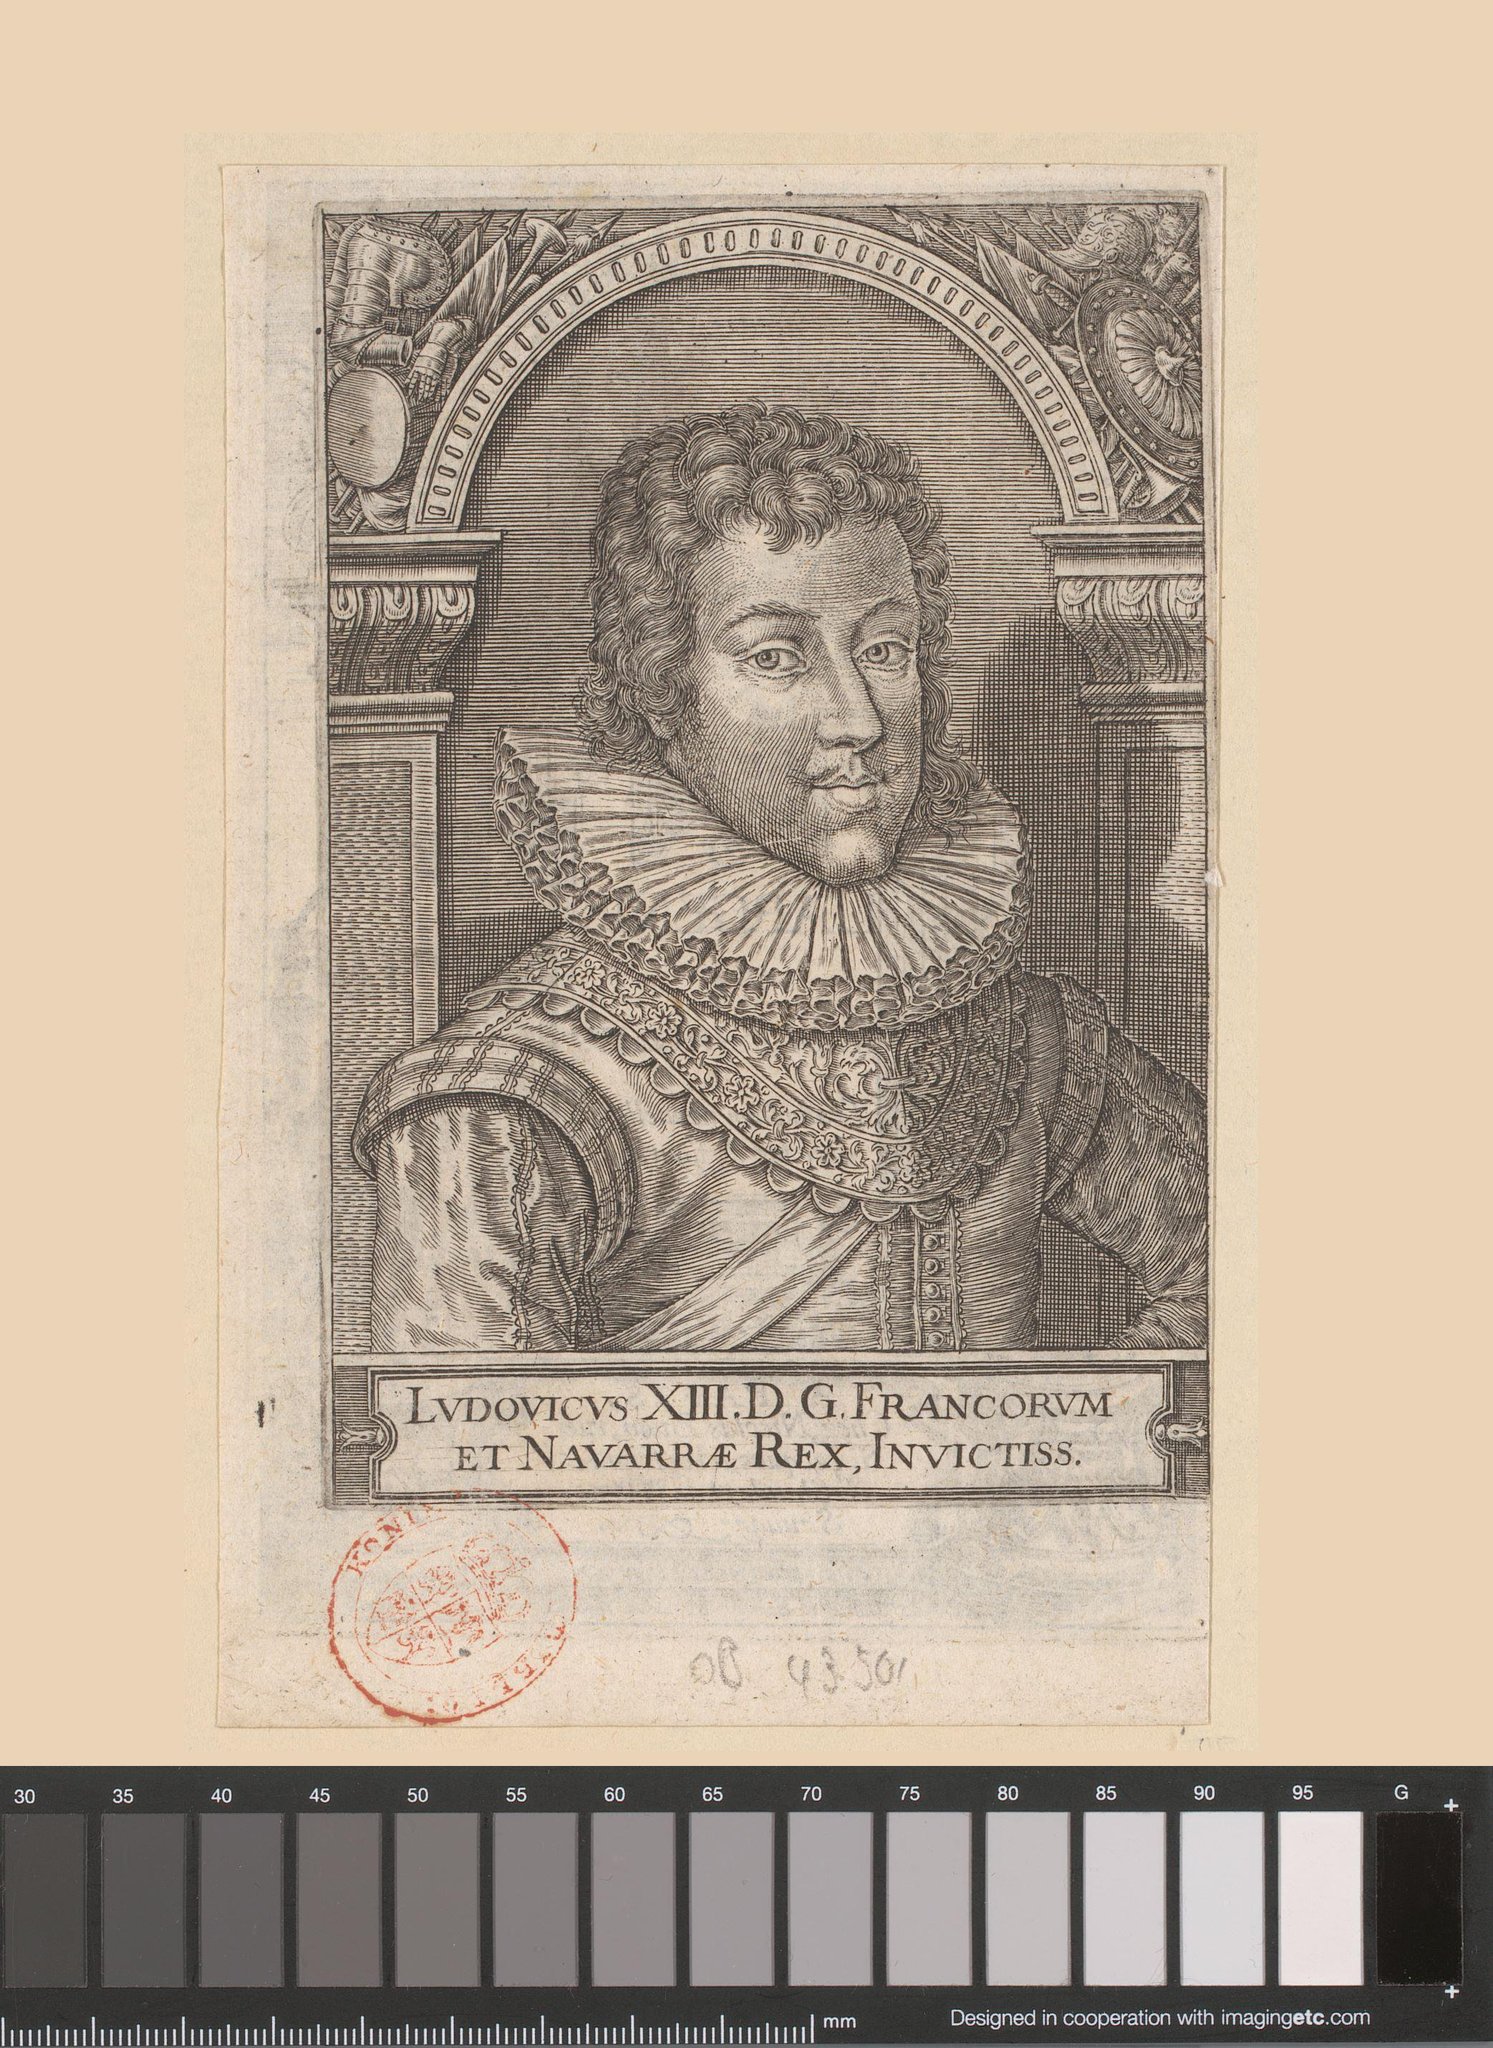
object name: print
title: Ludovicus XIII.D.G. Francorum et Navarrae Rex, Invictiss.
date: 1624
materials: paper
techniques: engraving, etching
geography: france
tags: lodewijk xiii (koning van frankrijk), historical persons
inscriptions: collector's mark: Lugt 240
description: Prent uit: Barclay, Jean. L'Argénis. Parijs: Claude Griset, 1624.